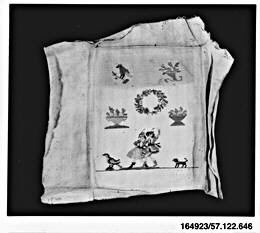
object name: sampler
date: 1801-1900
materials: linen, silk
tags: animals,birds